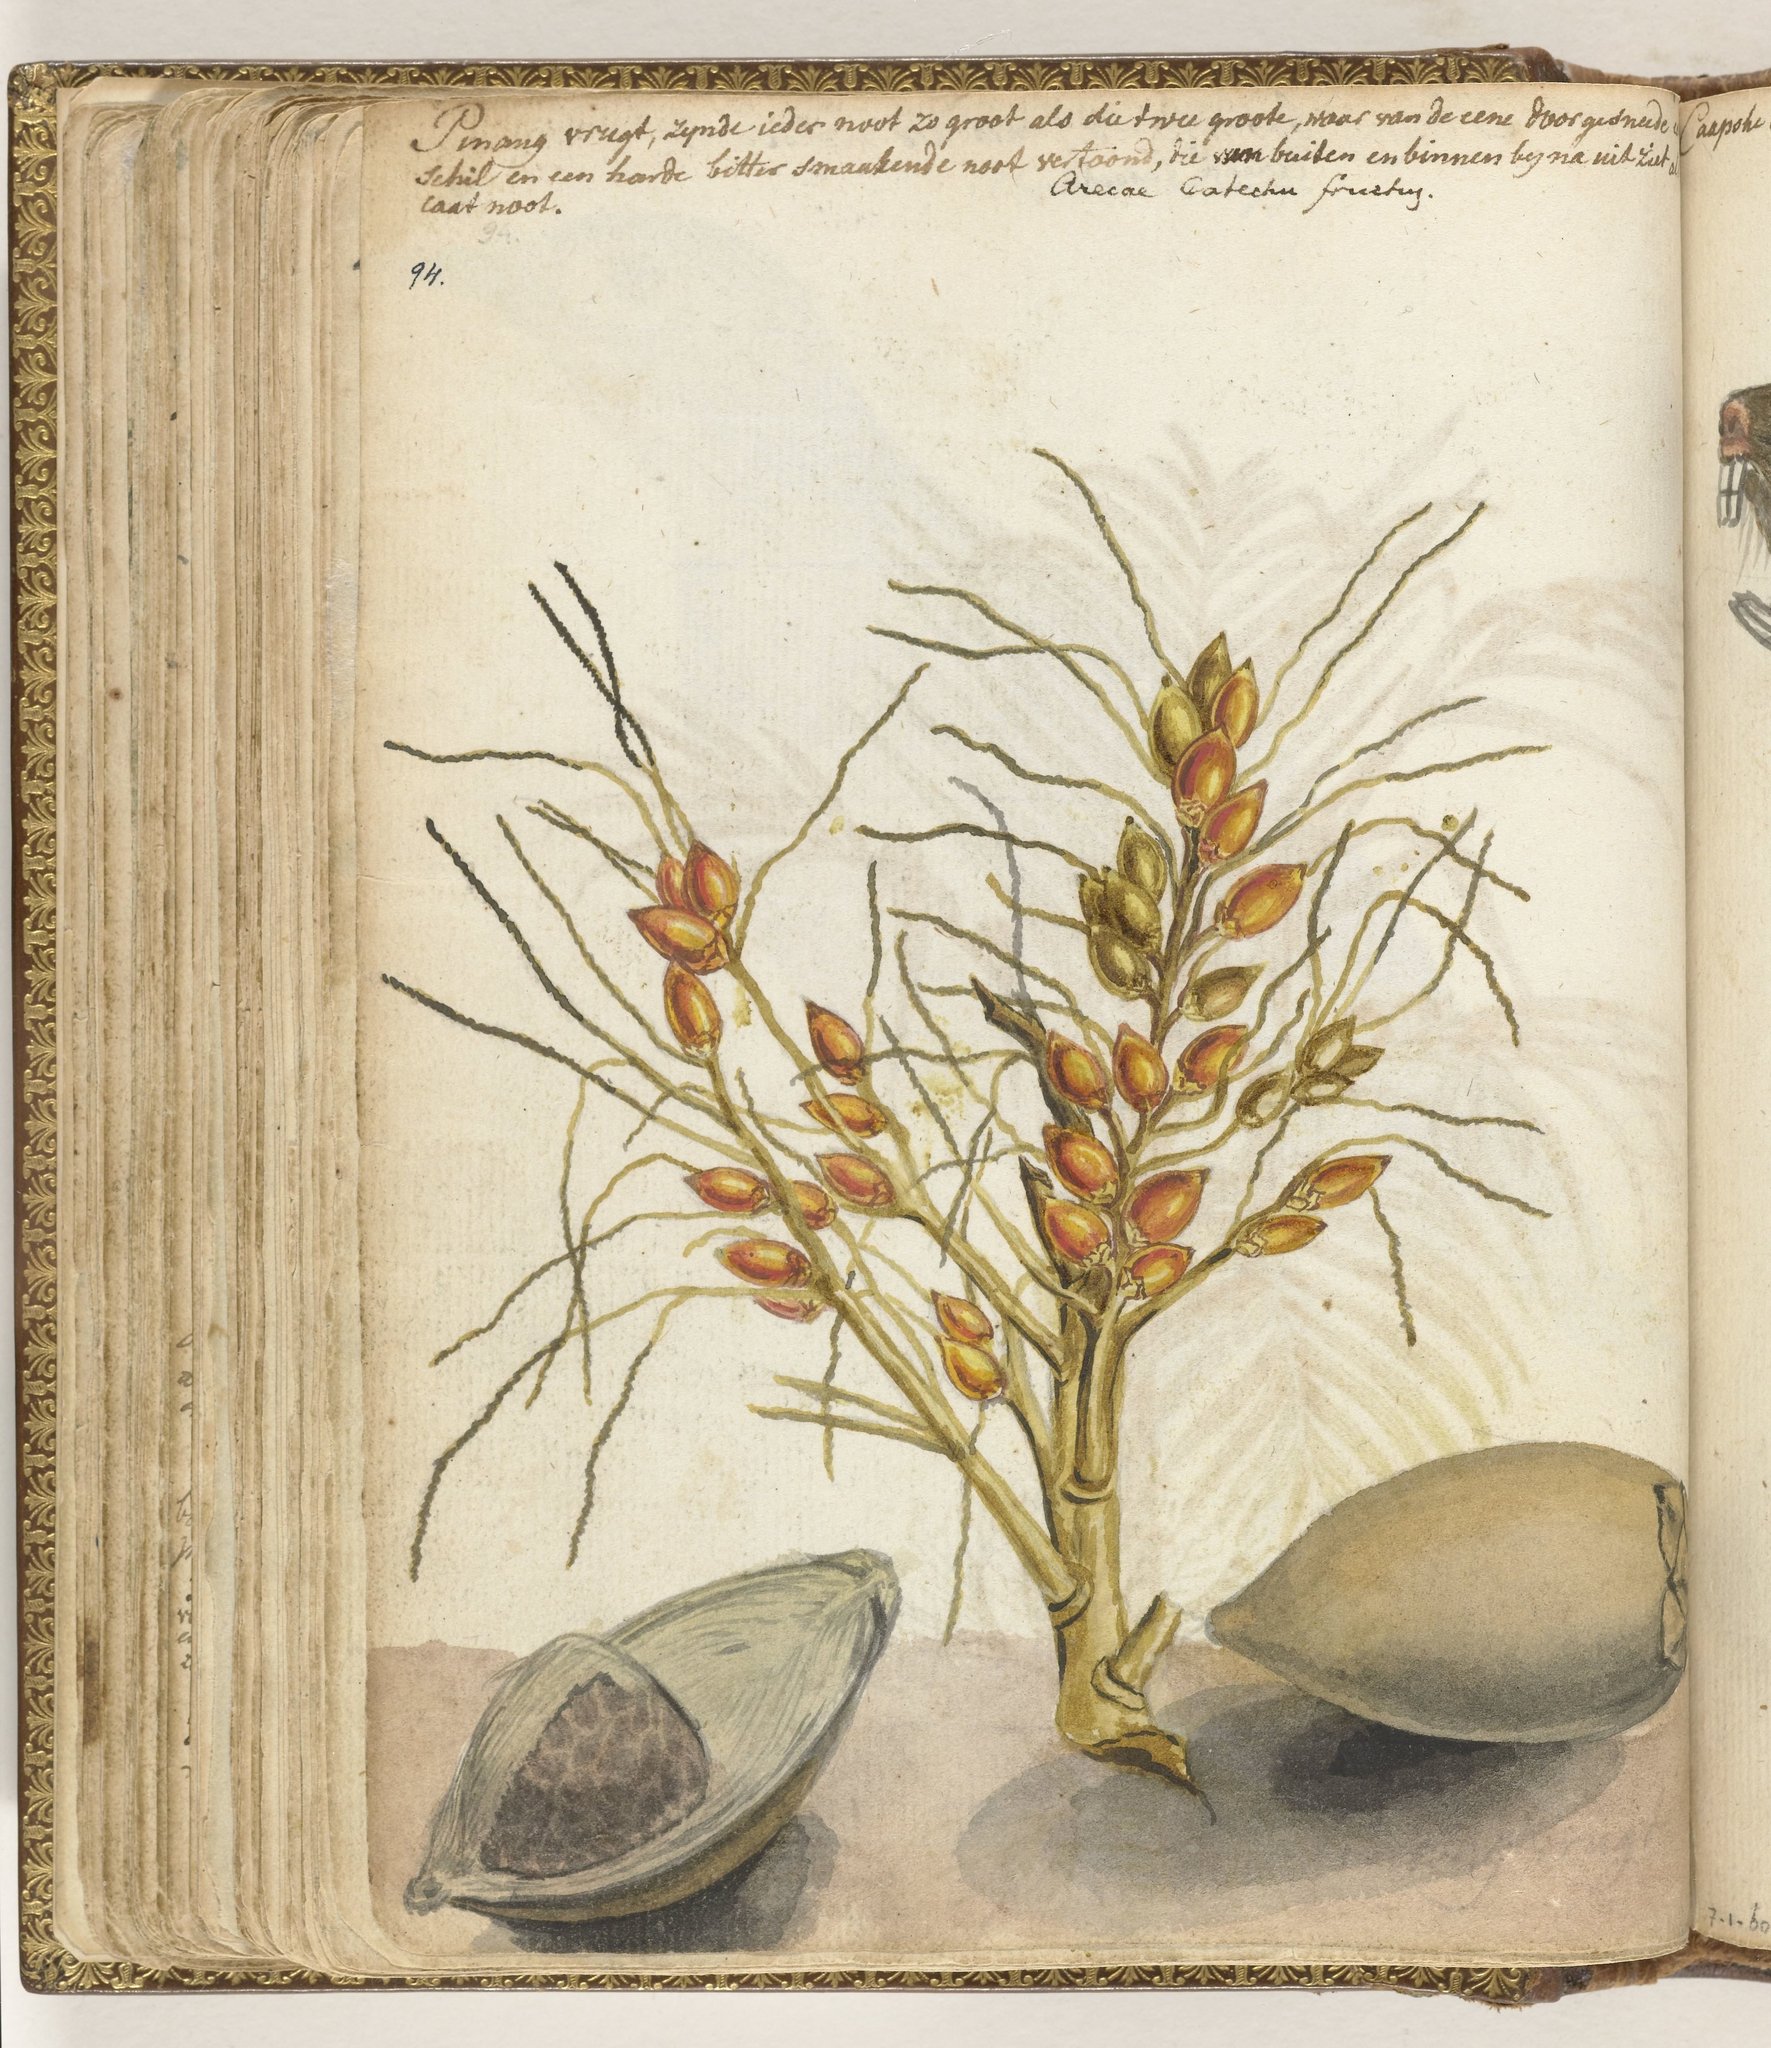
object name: drawing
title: Pinangvruchten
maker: jan brandes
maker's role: draughtsman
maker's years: 1743-1808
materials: paper, pencil, watercolor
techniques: brush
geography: jakarta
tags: fruits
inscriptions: inscription: ‘Pinang vrugt, zynde ieder noot zo groot als die twee groote, waar van de eene doorgesneede een haairige schil en een harde bitter smaakende noot vertoond, die van buiten en binnen byna uitziet als een muscaat noot. Areca Catechu fructus.’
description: Kleurtekening van een tak met pinangvruchten en twee pinangvruchten op ware grootte, waarvan één doorgesneden. Met opschrift. Onderdeel uit het schetsboek van Jan Brandes, dl. 1 (1808), p. 94 en zie ook p. 47-48, 93, 203.